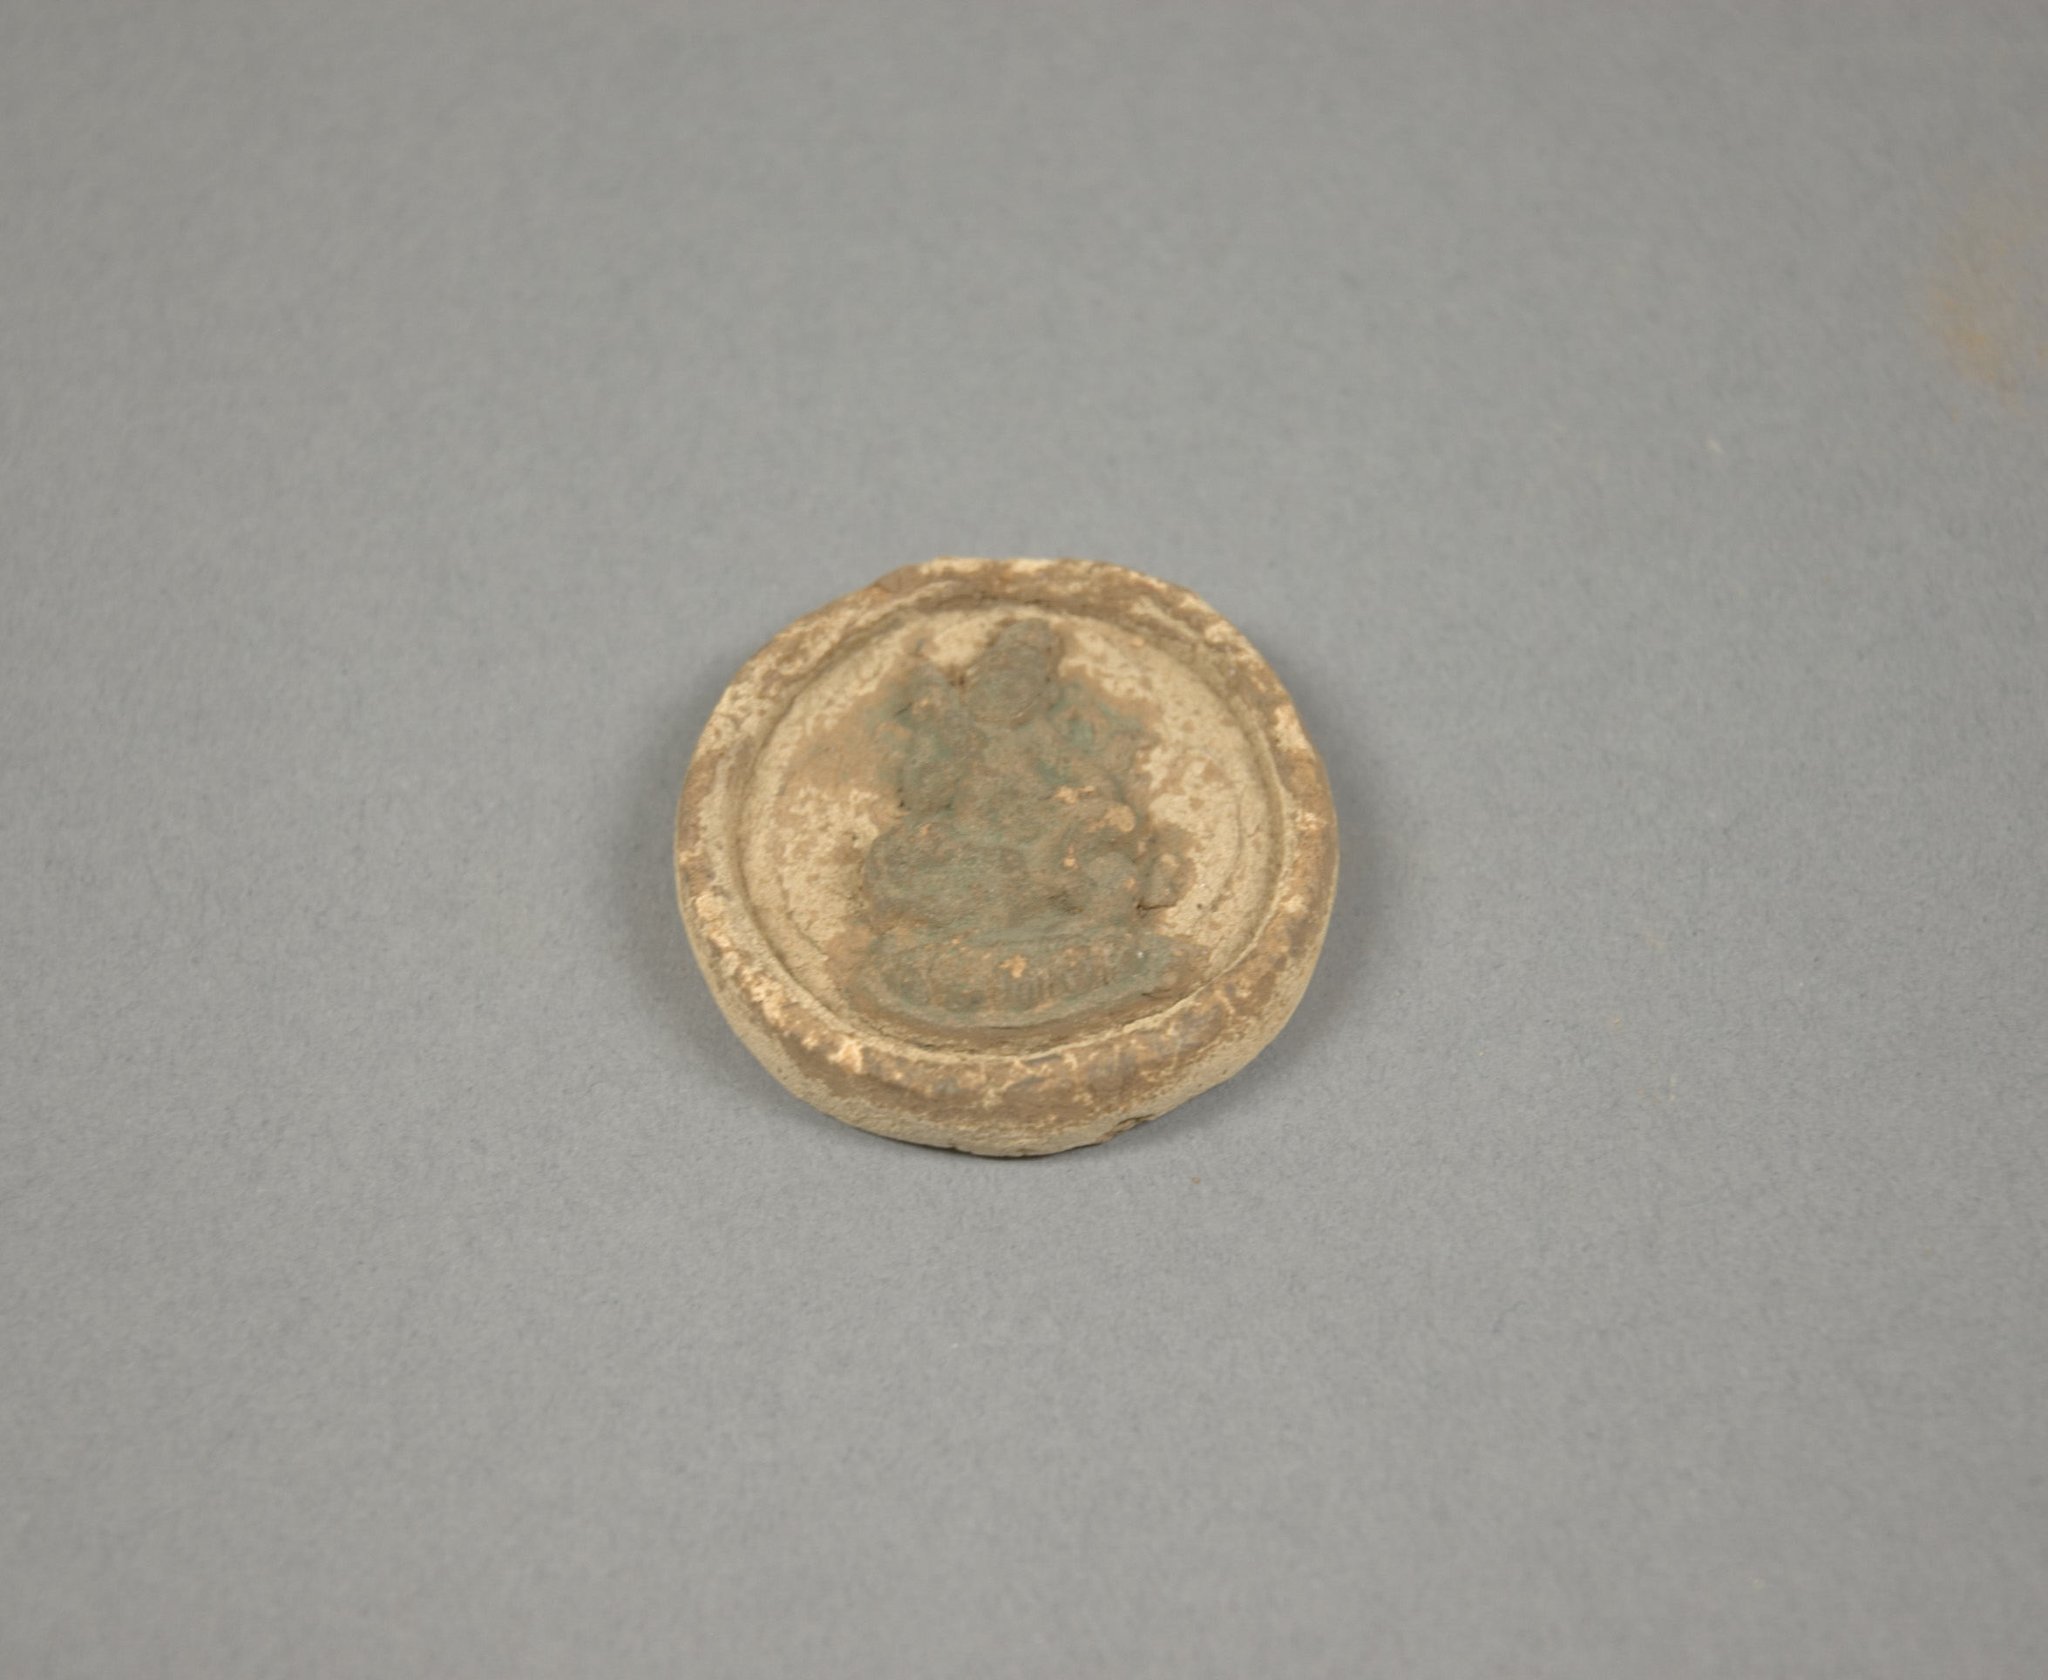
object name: plaque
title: Votive Plaque with Seated Figure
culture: tibetan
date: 1368-1643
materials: clay